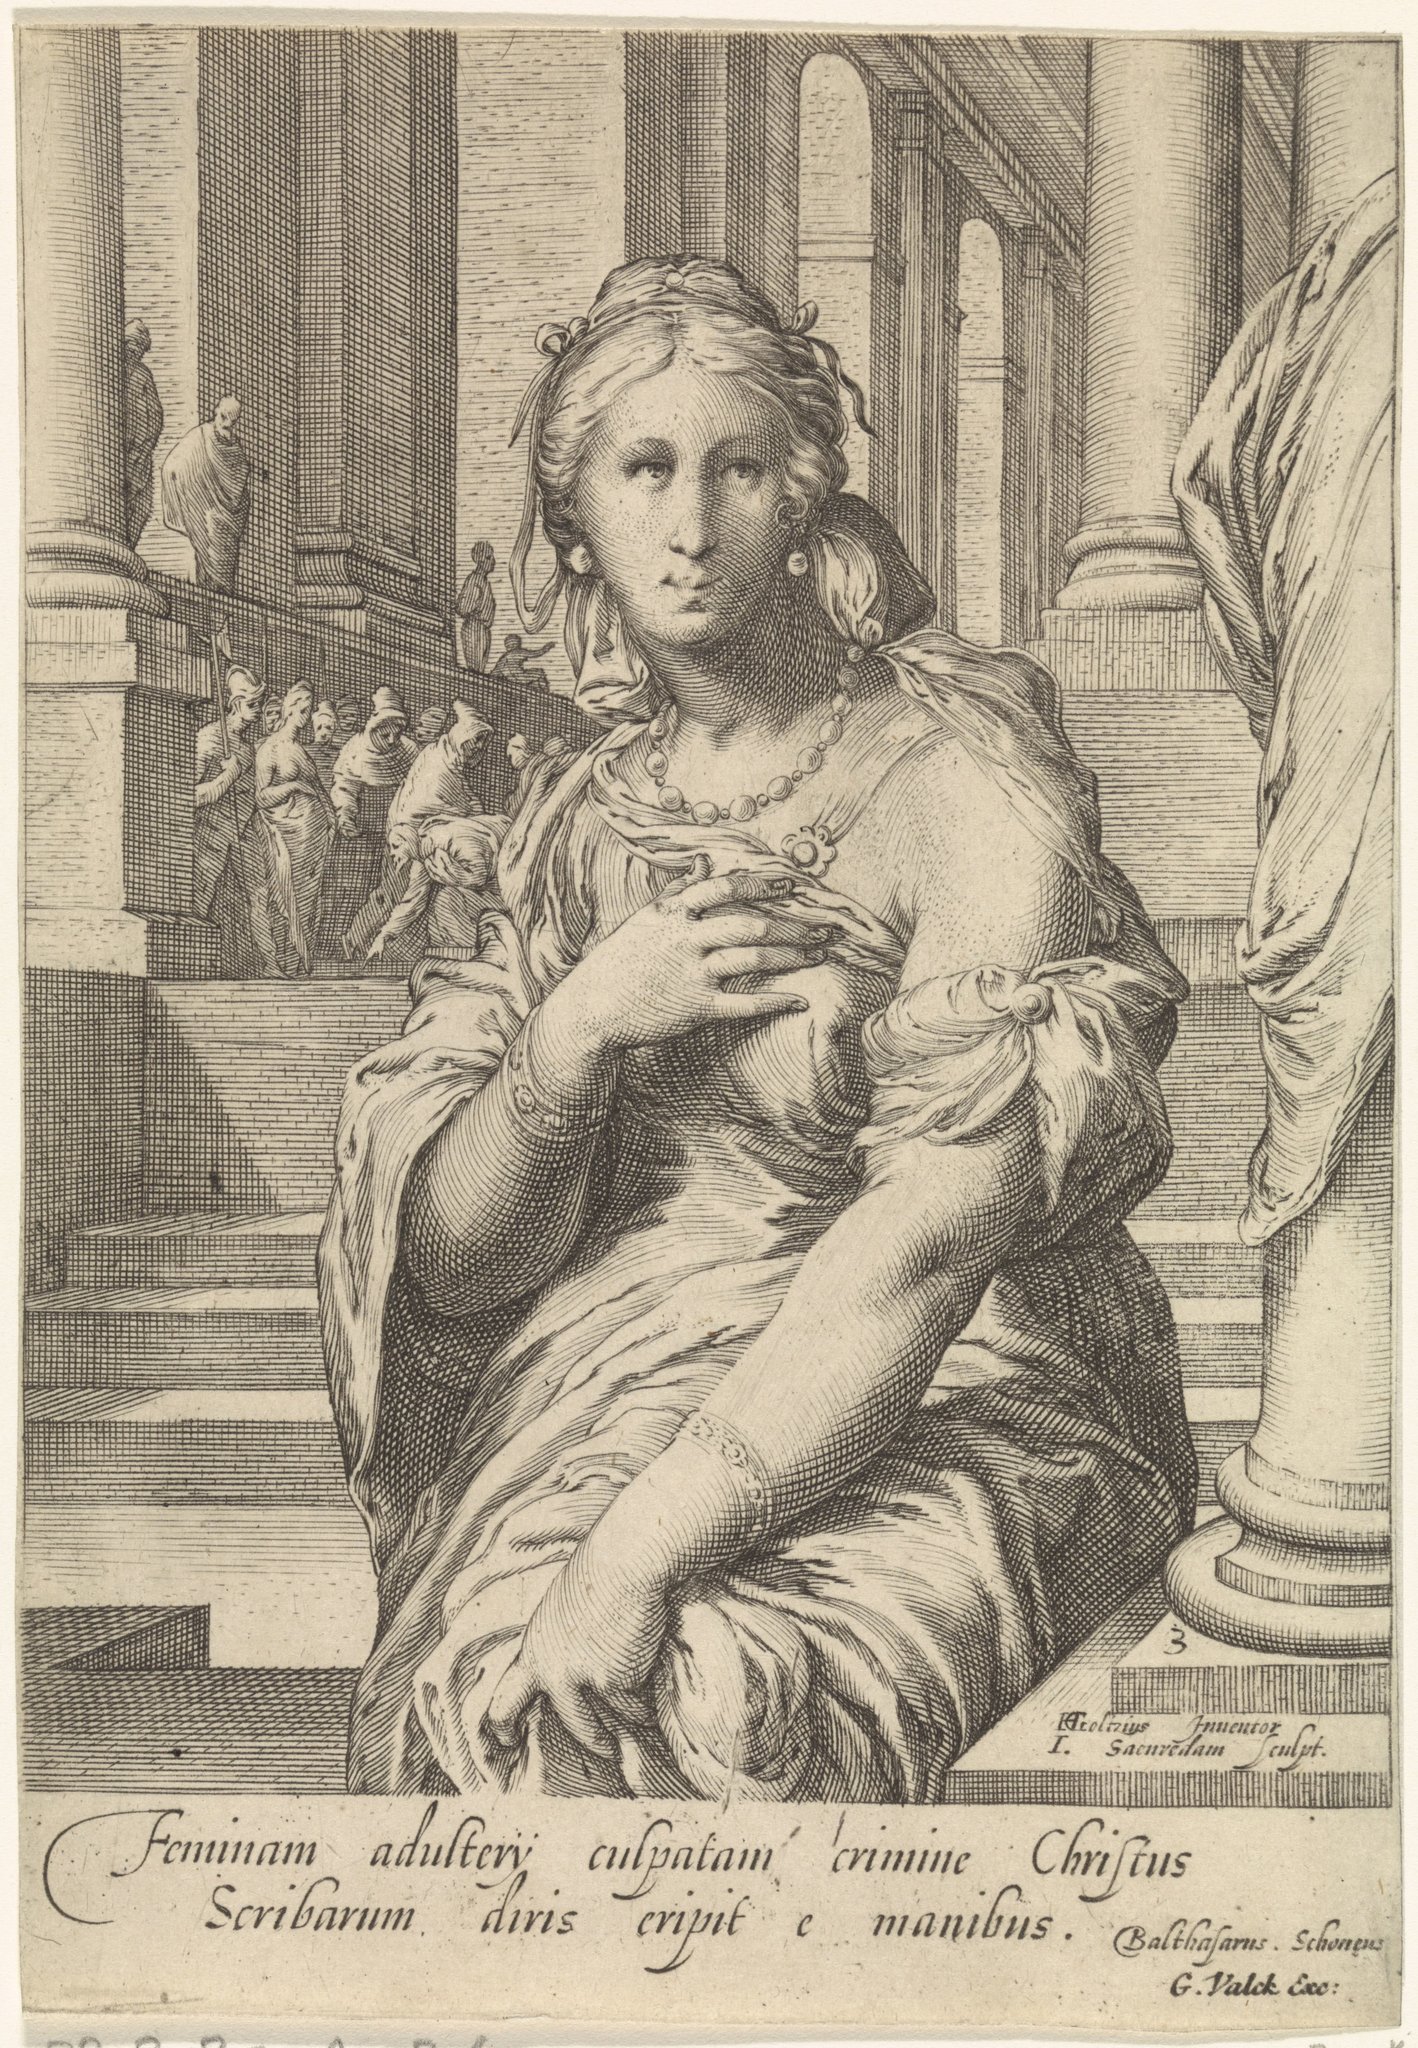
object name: print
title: De overspelige vrouw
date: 1661-1726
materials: paper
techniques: engraving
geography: amsterdam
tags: christ points to or writes on the ground, pharisees bring a woman accused of adultery before christ (john 8:2-11)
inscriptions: collector's mark: Lugt 2228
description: De overspelige vrou, voor een temple. Op de achtergrond de Farizeeën die een overspelige vrouw naar Christus toebrengen in de tempel. Christus schrijft met zijn vinger op de grond. De prent heeft een Latijns onderschrift en maakt deel uit van een prentserie met beroemde vrouwen uit het Nieuwe Testament